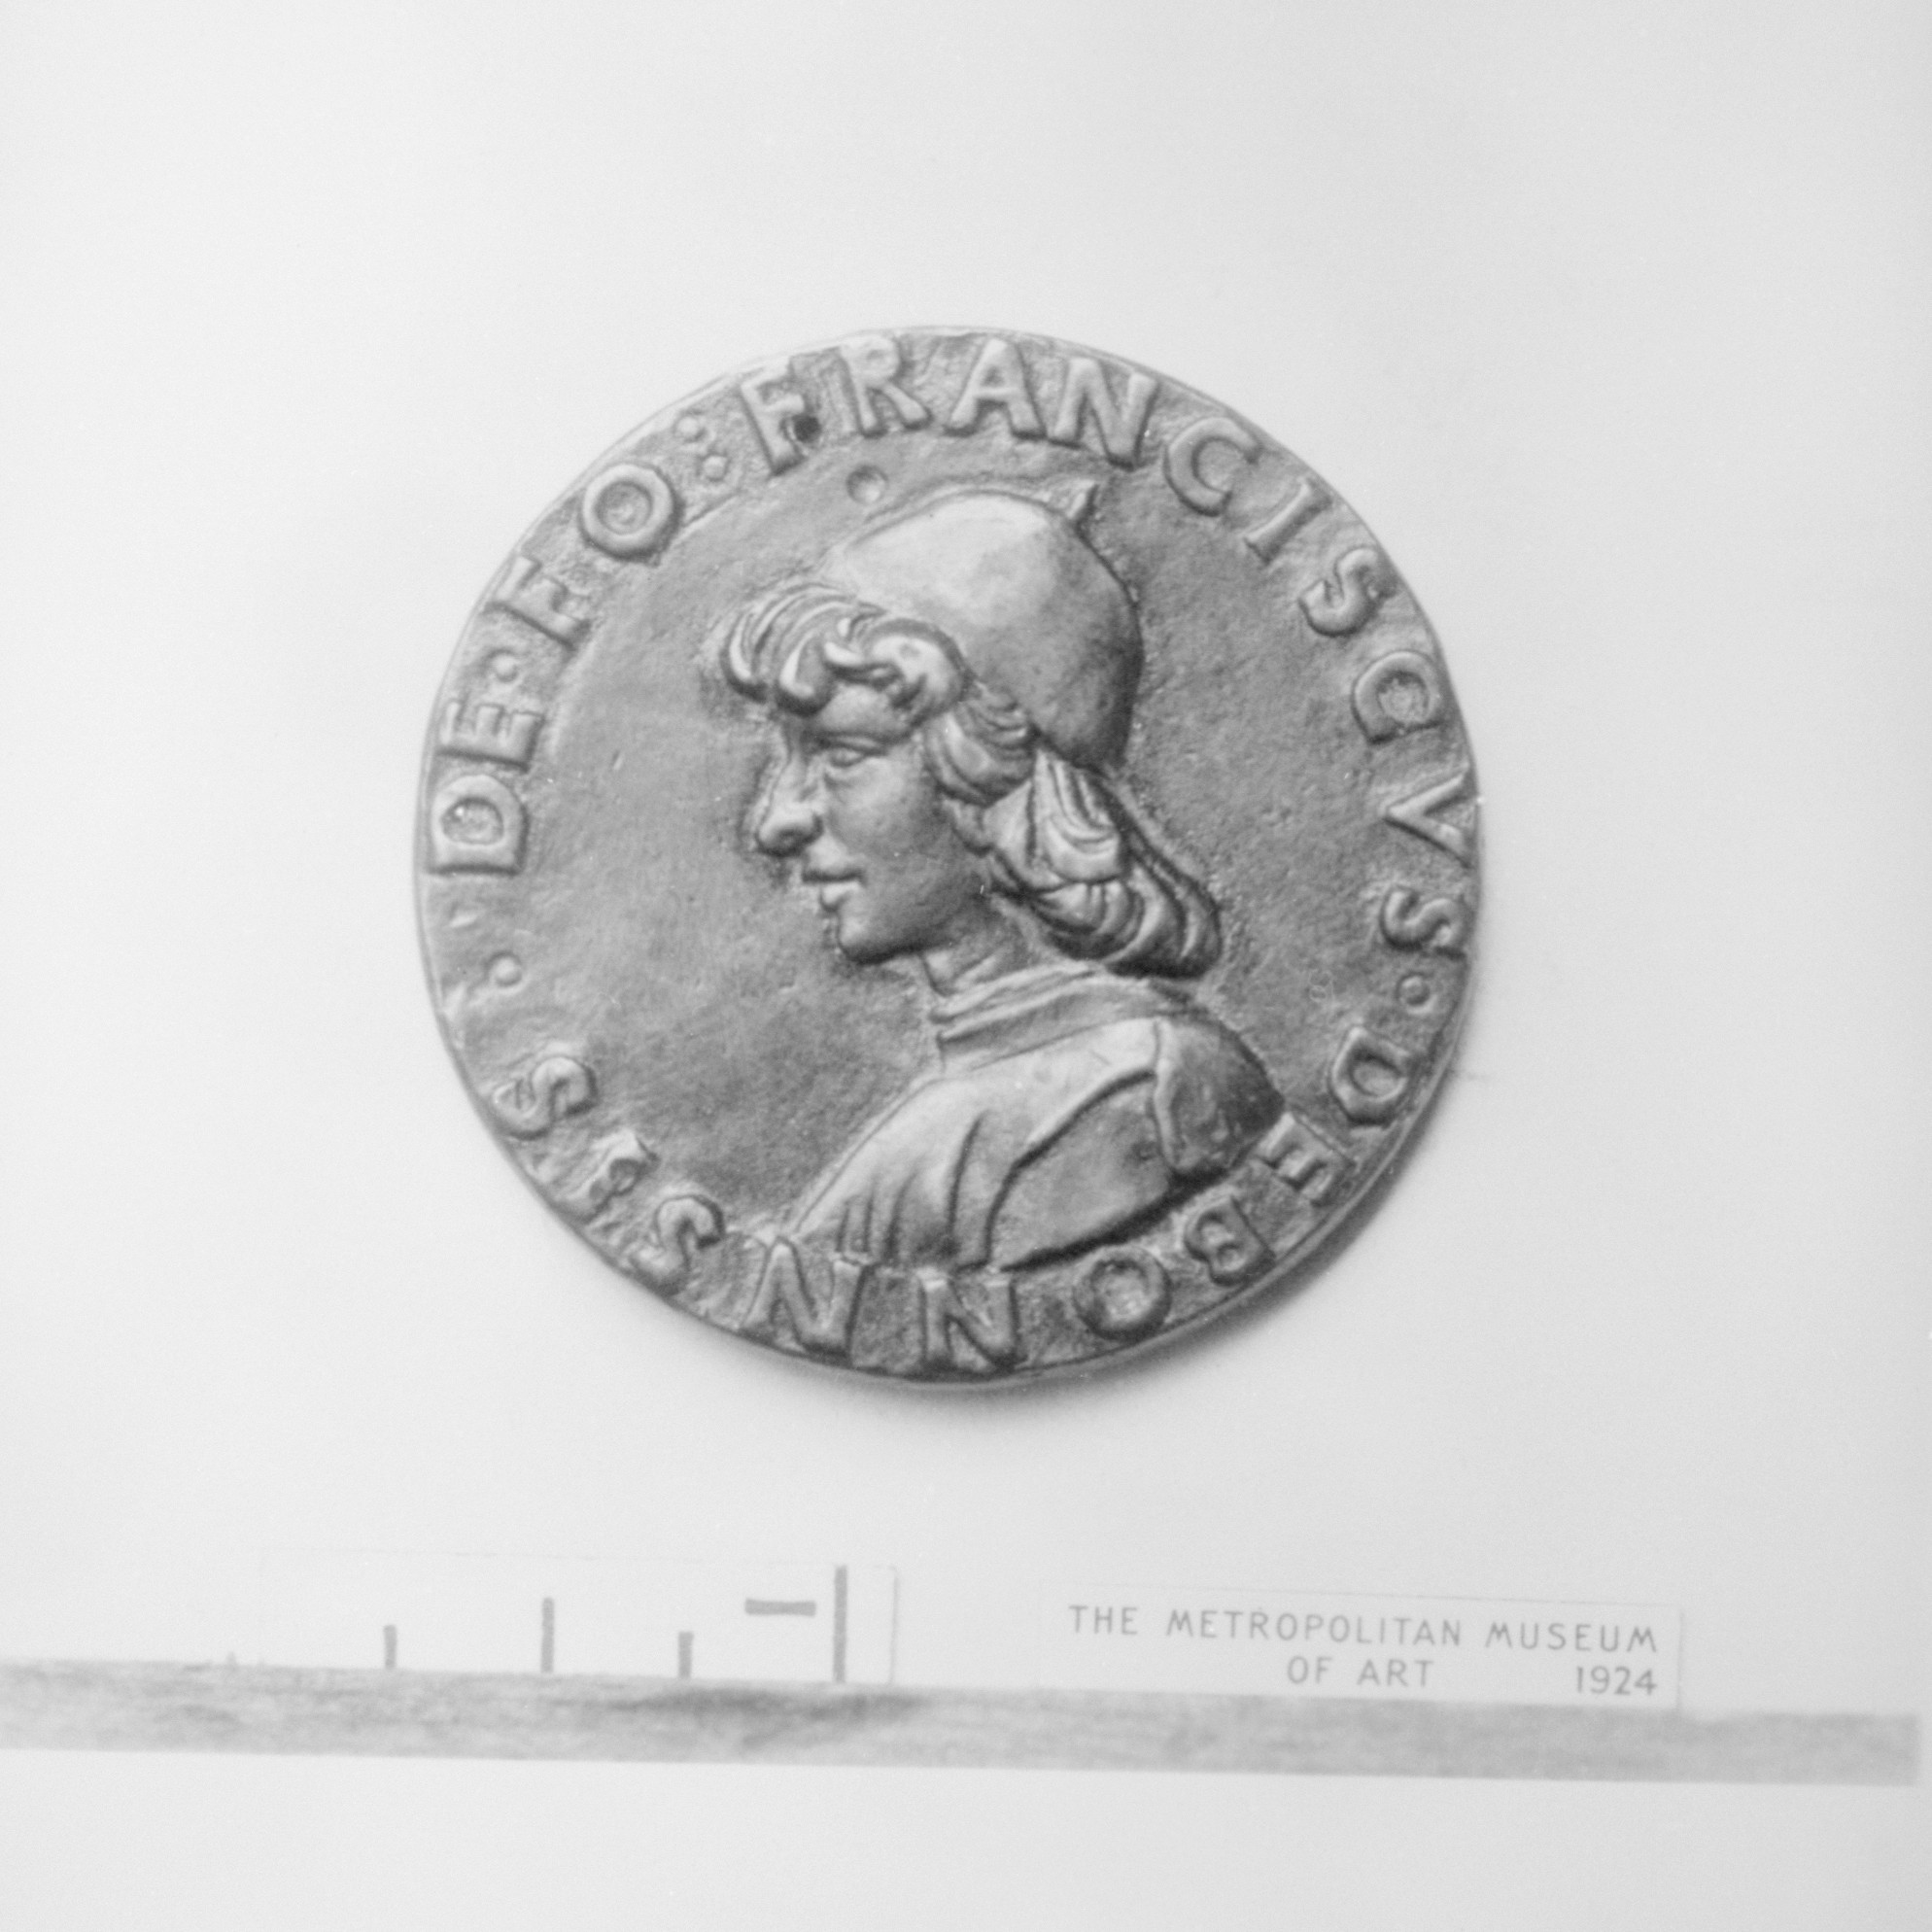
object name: medal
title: Francesco Bonsi della Ruota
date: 1484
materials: bronze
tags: men,male nudes,profiles